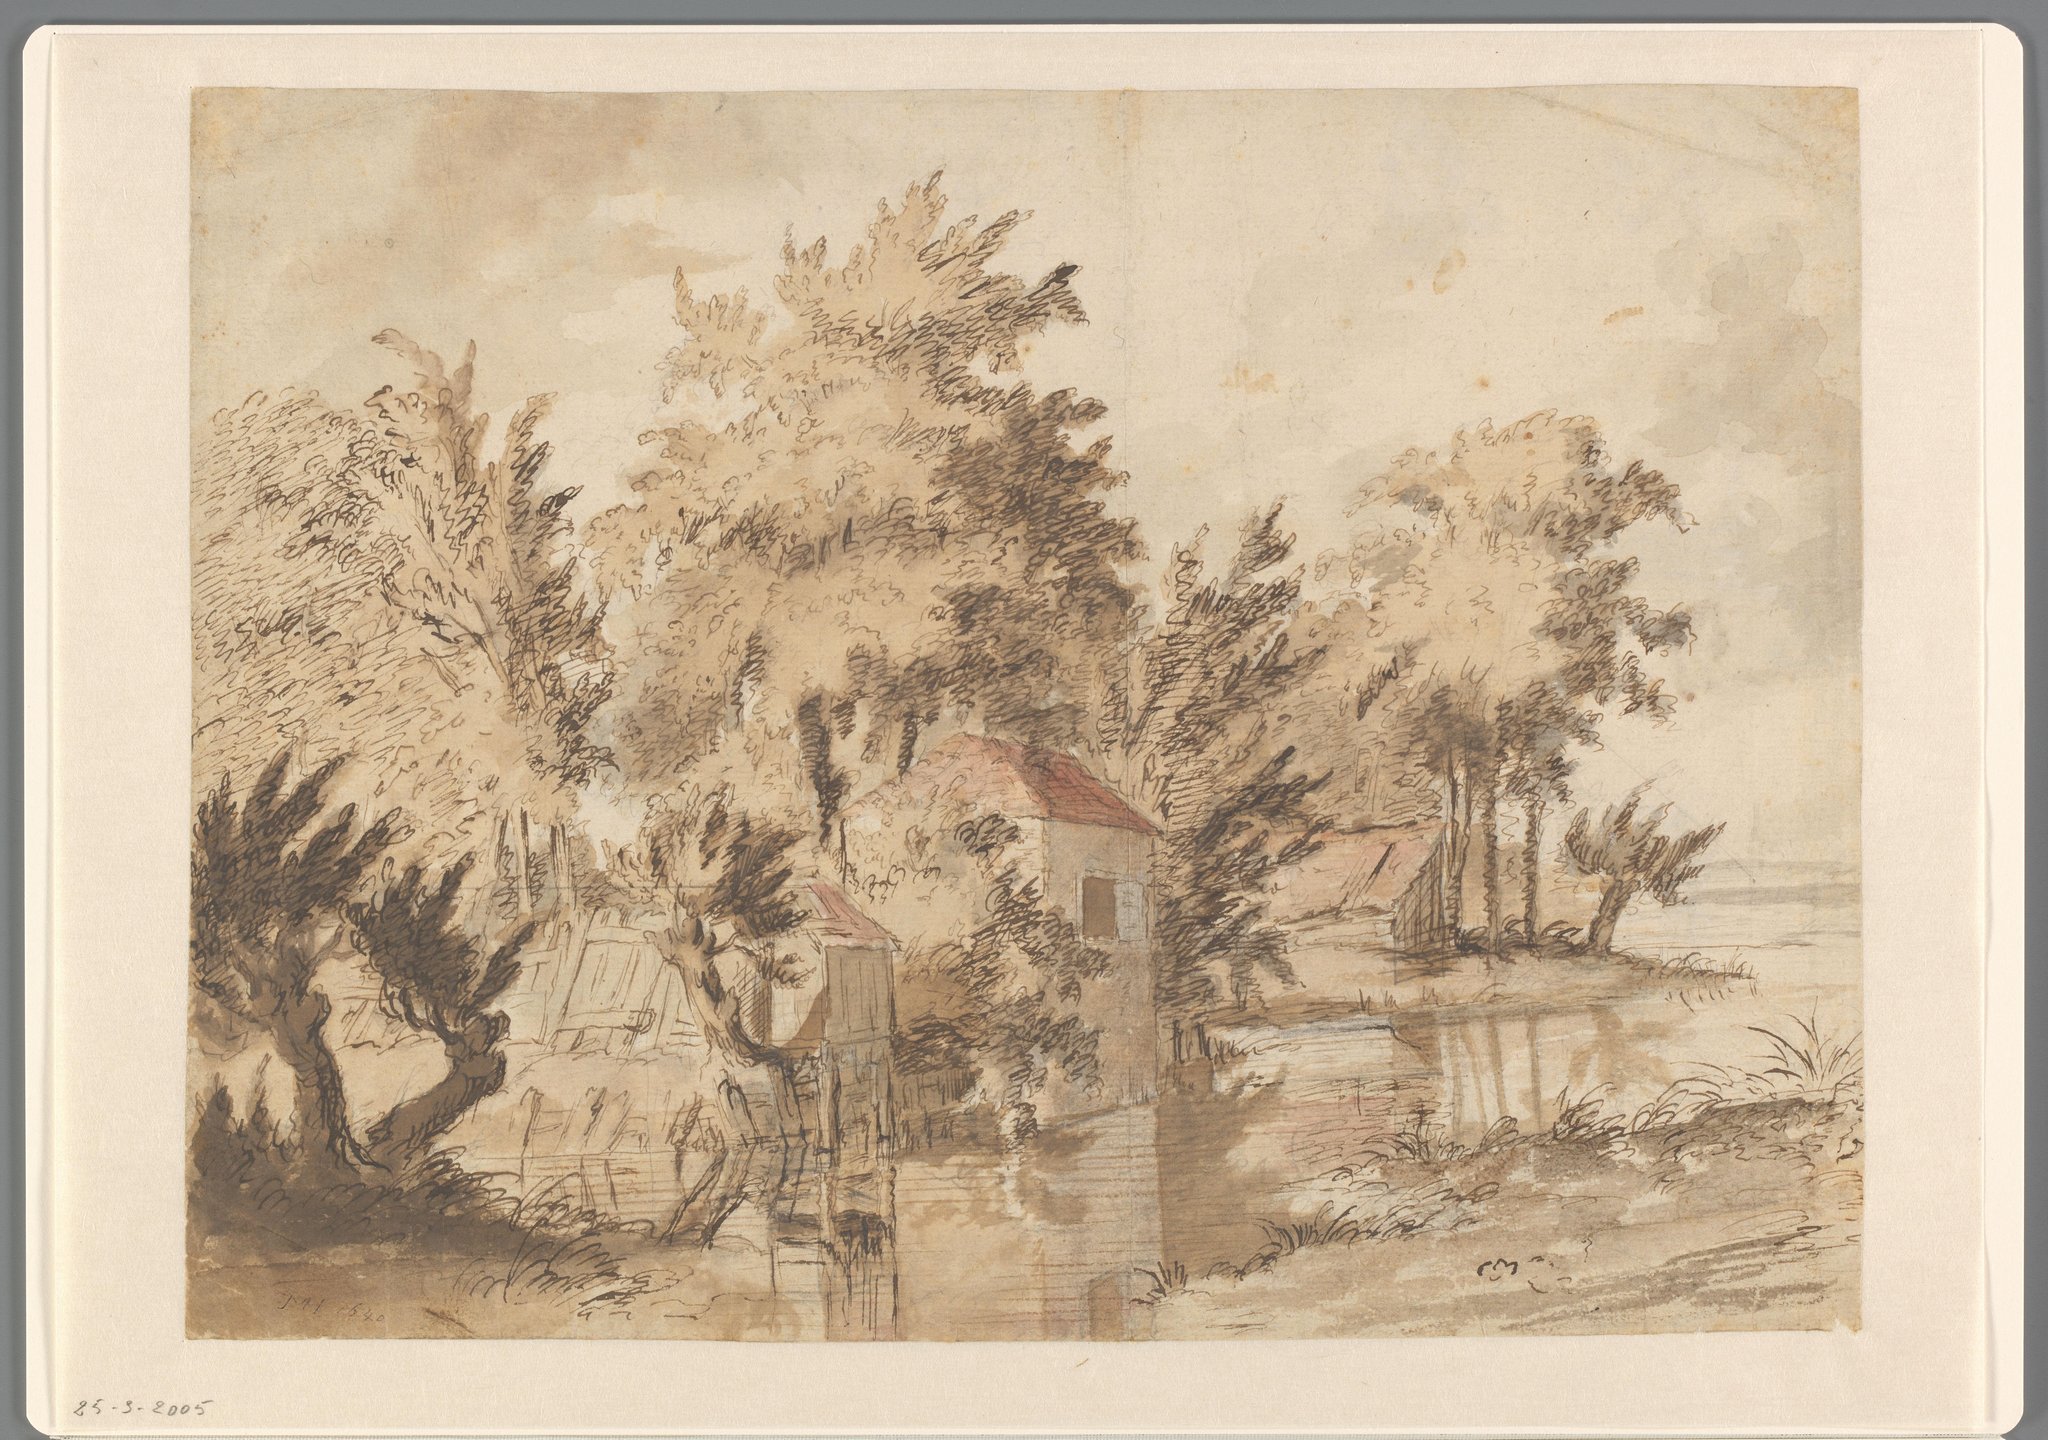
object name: drawing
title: Huizen aan het water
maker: Anonymous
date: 1700-1800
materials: ink, paper, pencil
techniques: brush, pen